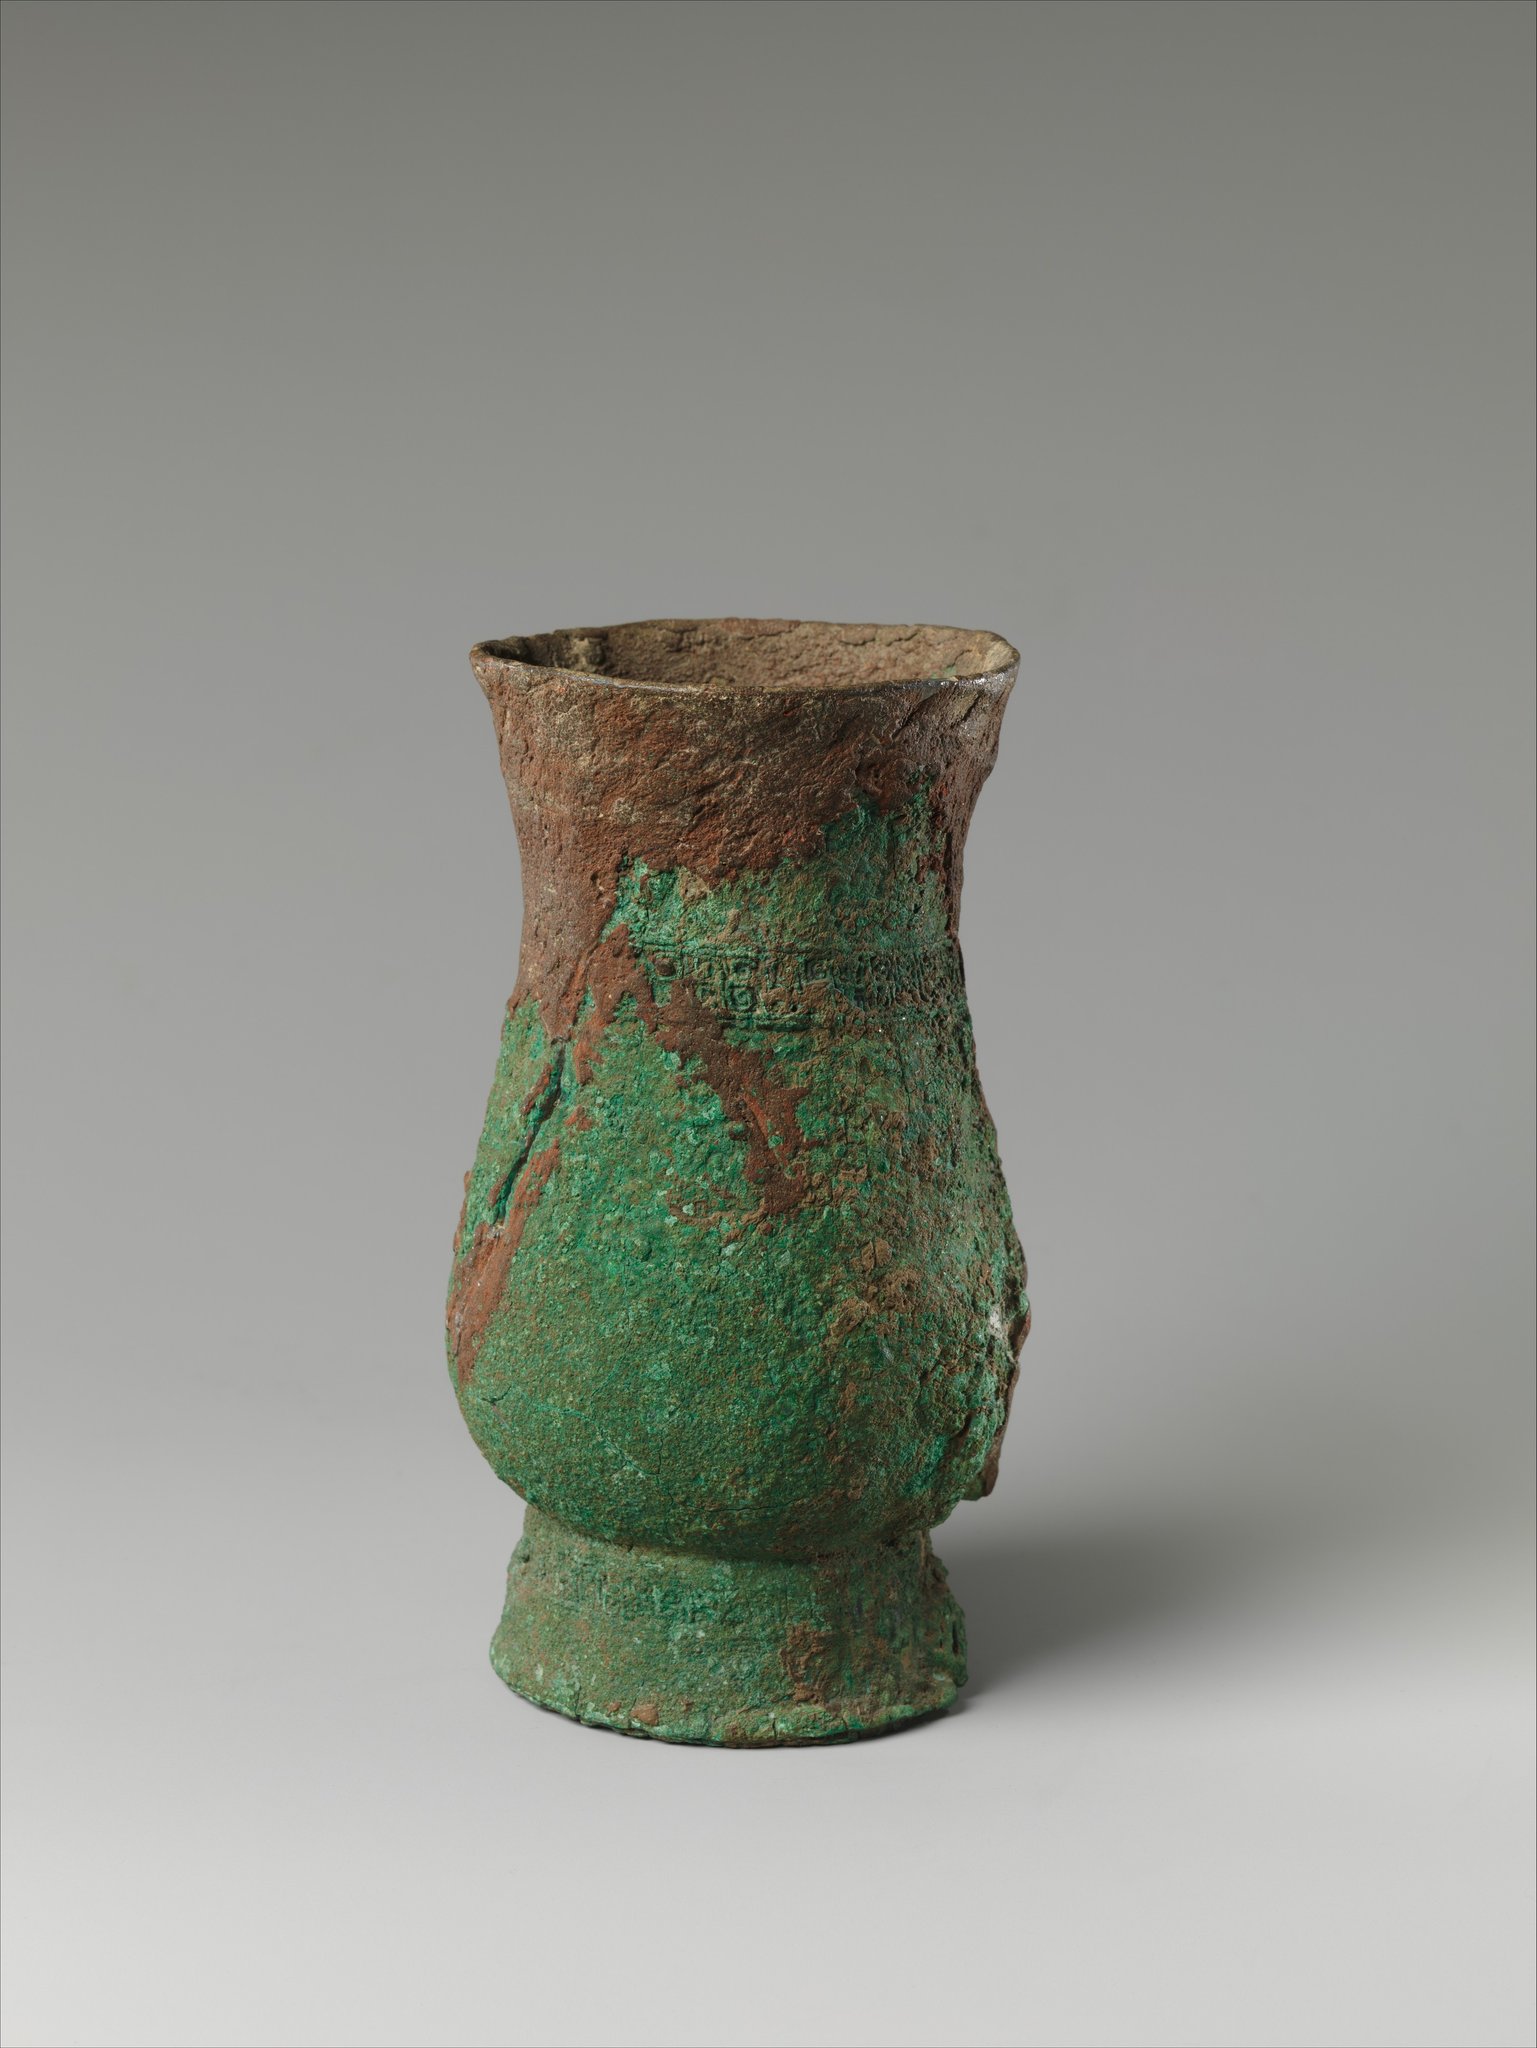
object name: wine cup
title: Ritual Wine Cup (Zhi)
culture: chinese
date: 1034-1001 BCE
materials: bronze